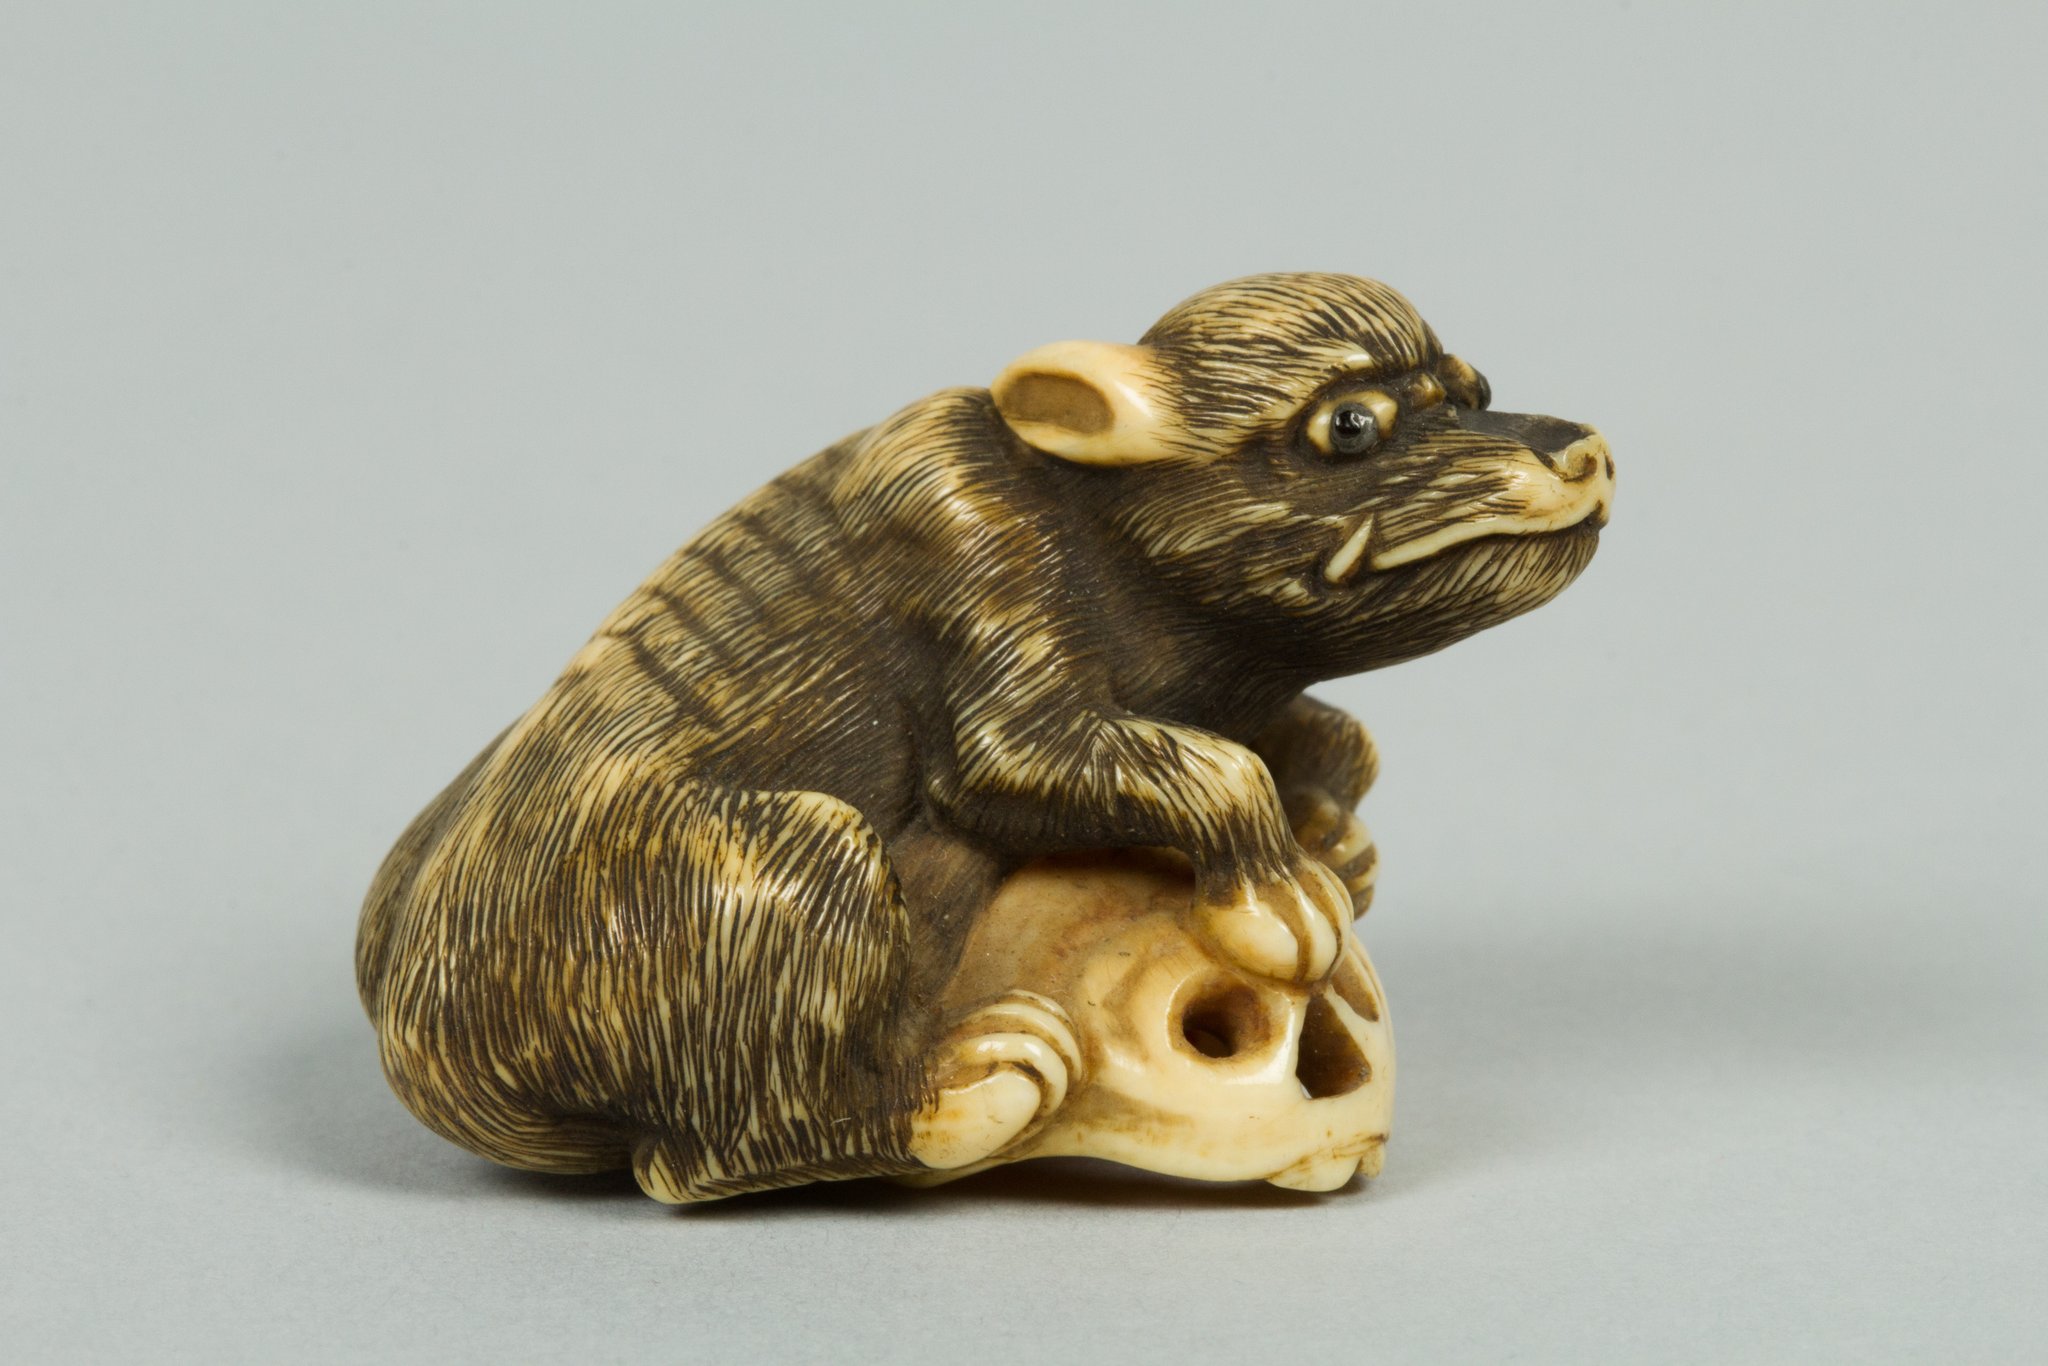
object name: netsuke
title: Netsuke of Boar with a Human Skull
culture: japanese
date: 1801-1900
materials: ivory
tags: skulls,boars